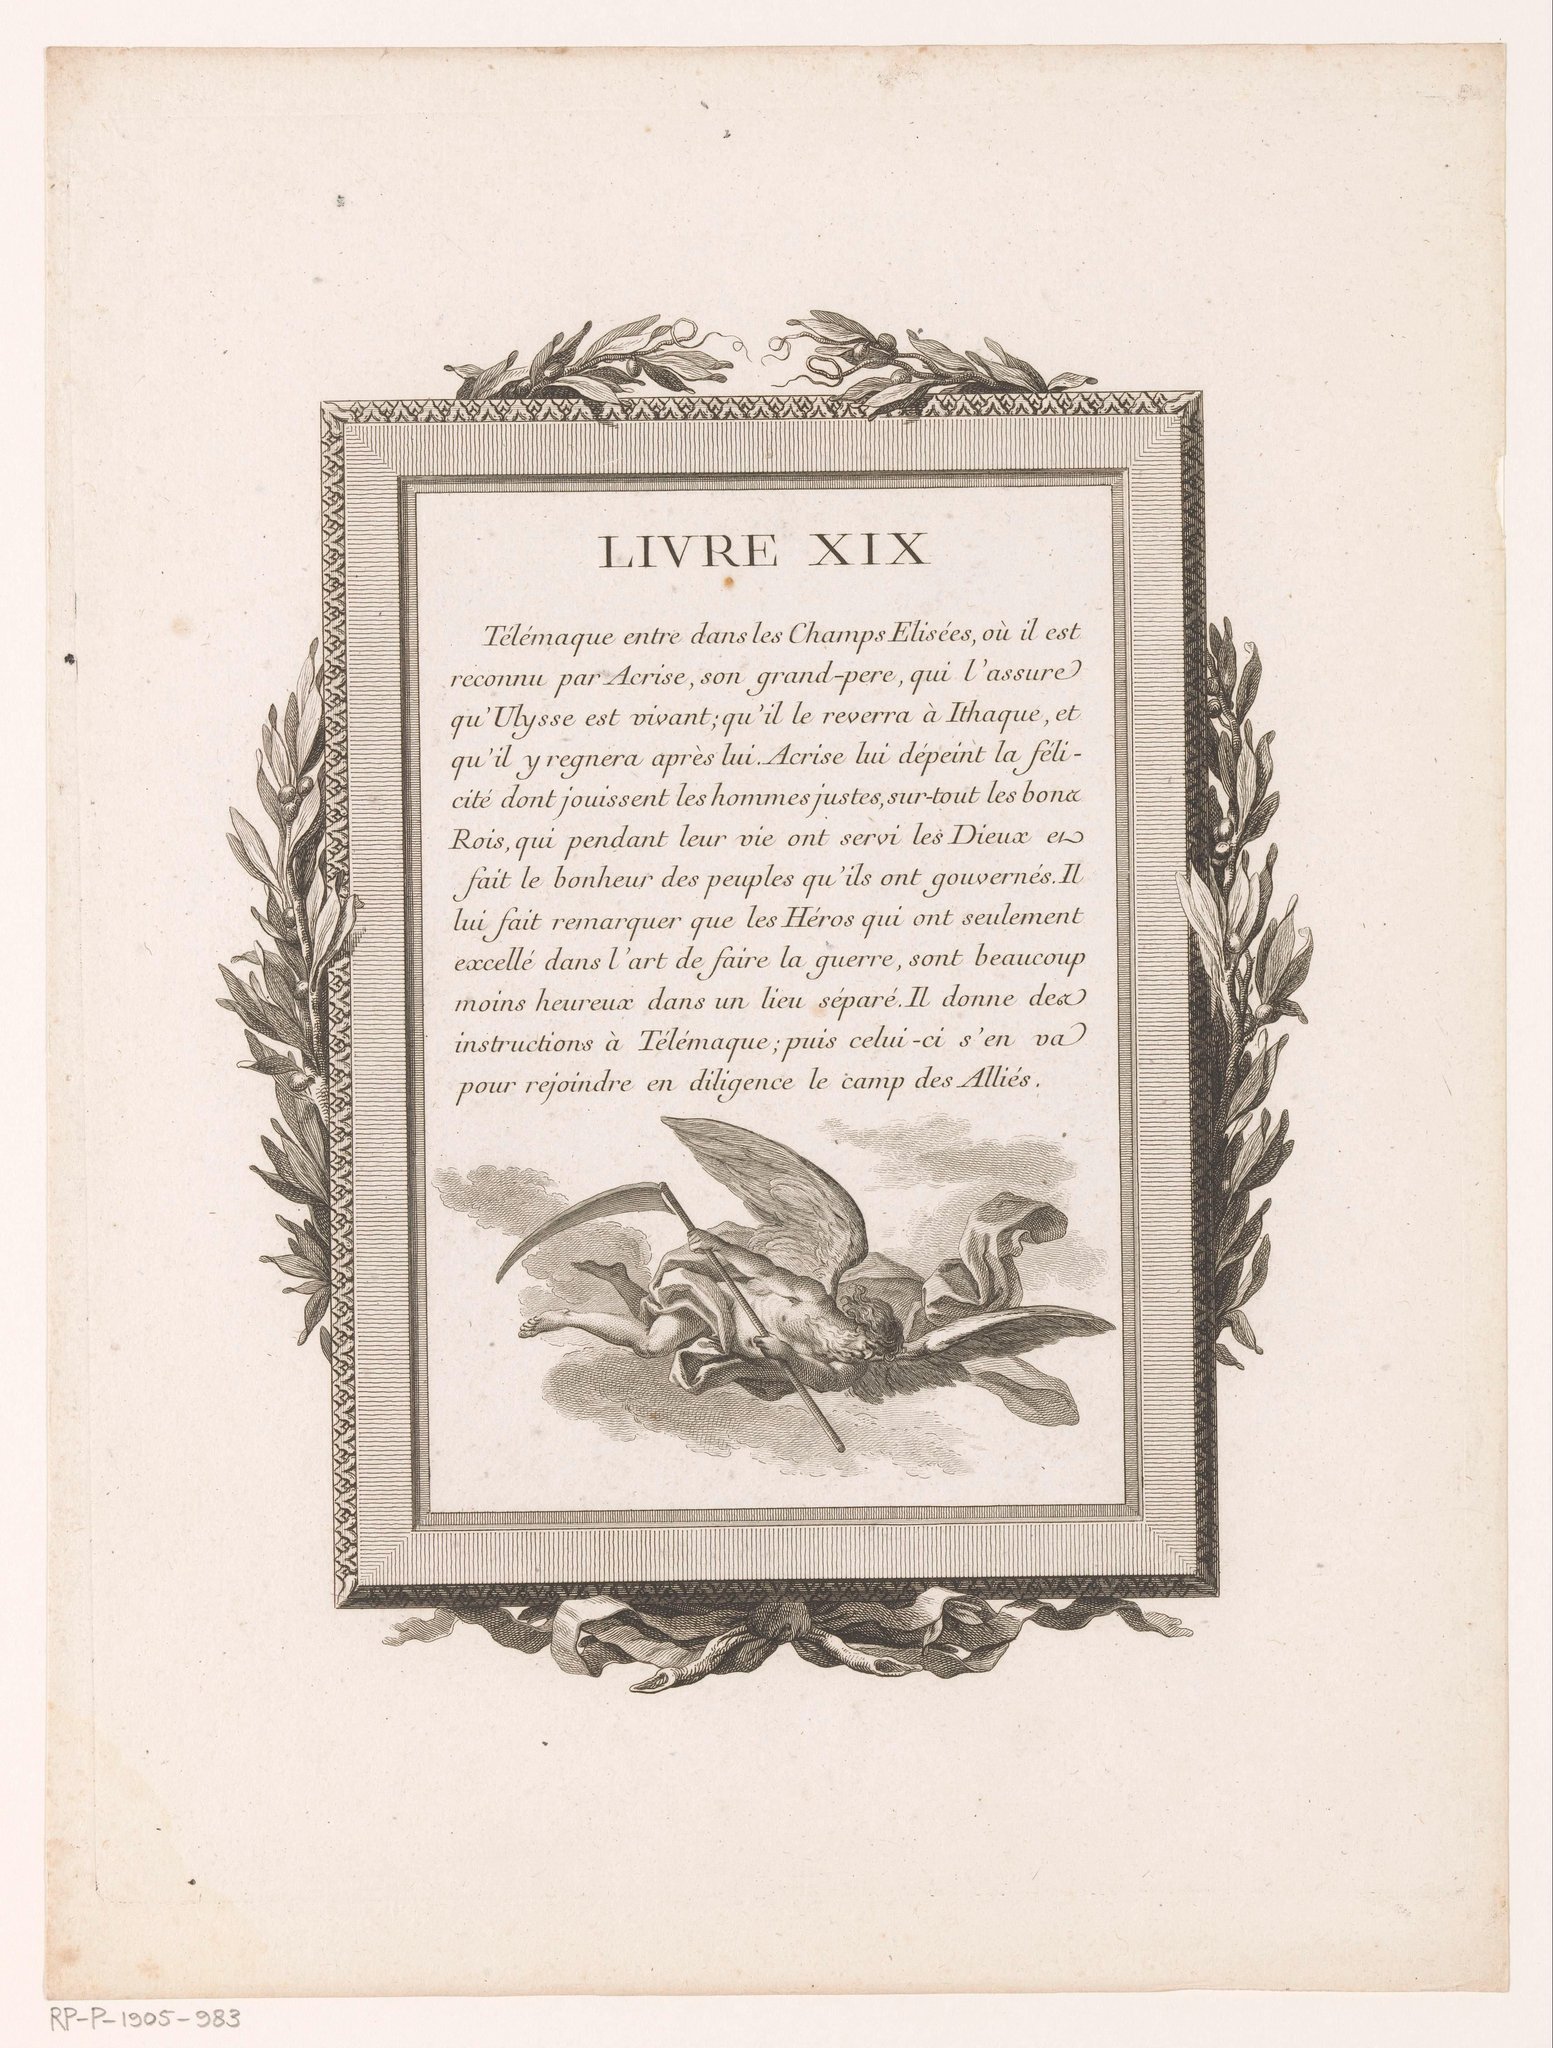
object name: book illustration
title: Omkaderde Franse tekst met olijftakken en de figuur Tijd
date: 1785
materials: paper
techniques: engraving, etching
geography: paris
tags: (fenelon, telemachus) specific works of literature (with author, title), ornament ~ festoon, garland, father time, man with wings and scythe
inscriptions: collector's mark: Lugt 2228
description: Twaalfregelige Franse tekst, getiteld 'Livre XIX' met daaronder een afbeelding van de Tijd met een zeis in zijn handen. Het geheel wordt gekaderd door een sierlijst met olijftakken en onderaan een strik.